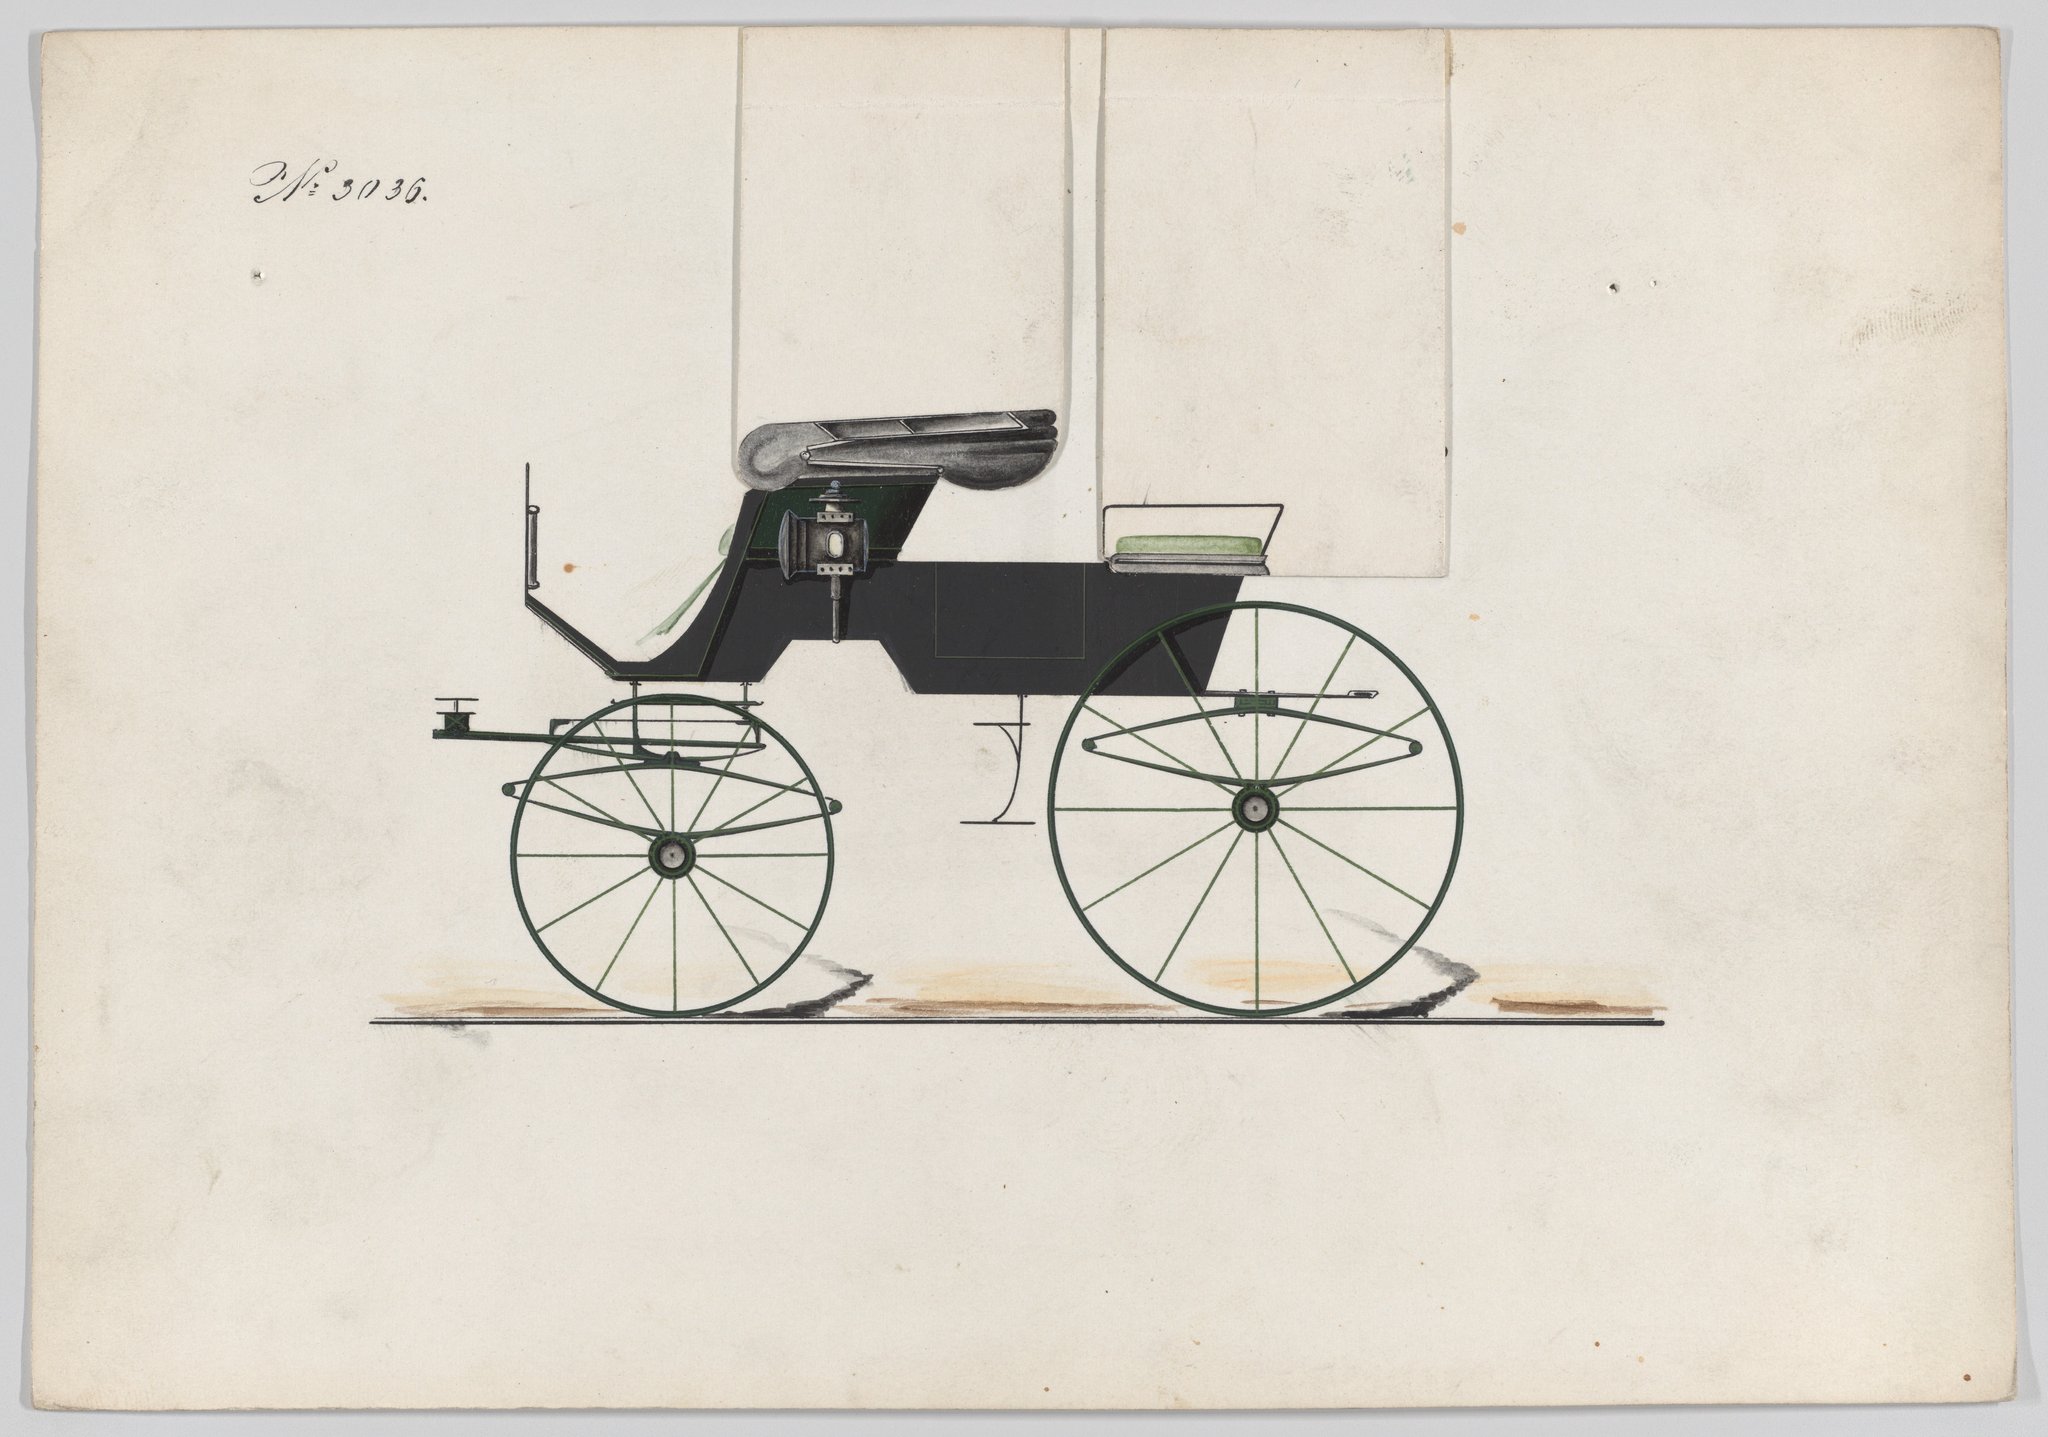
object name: drawing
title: Design for 2 seat Phaeton, no. 3036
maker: brewster & co.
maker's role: manufacturer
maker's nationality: american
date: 1874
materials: gouache, gum arabic, ink, watercolor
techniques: pen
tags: carriages